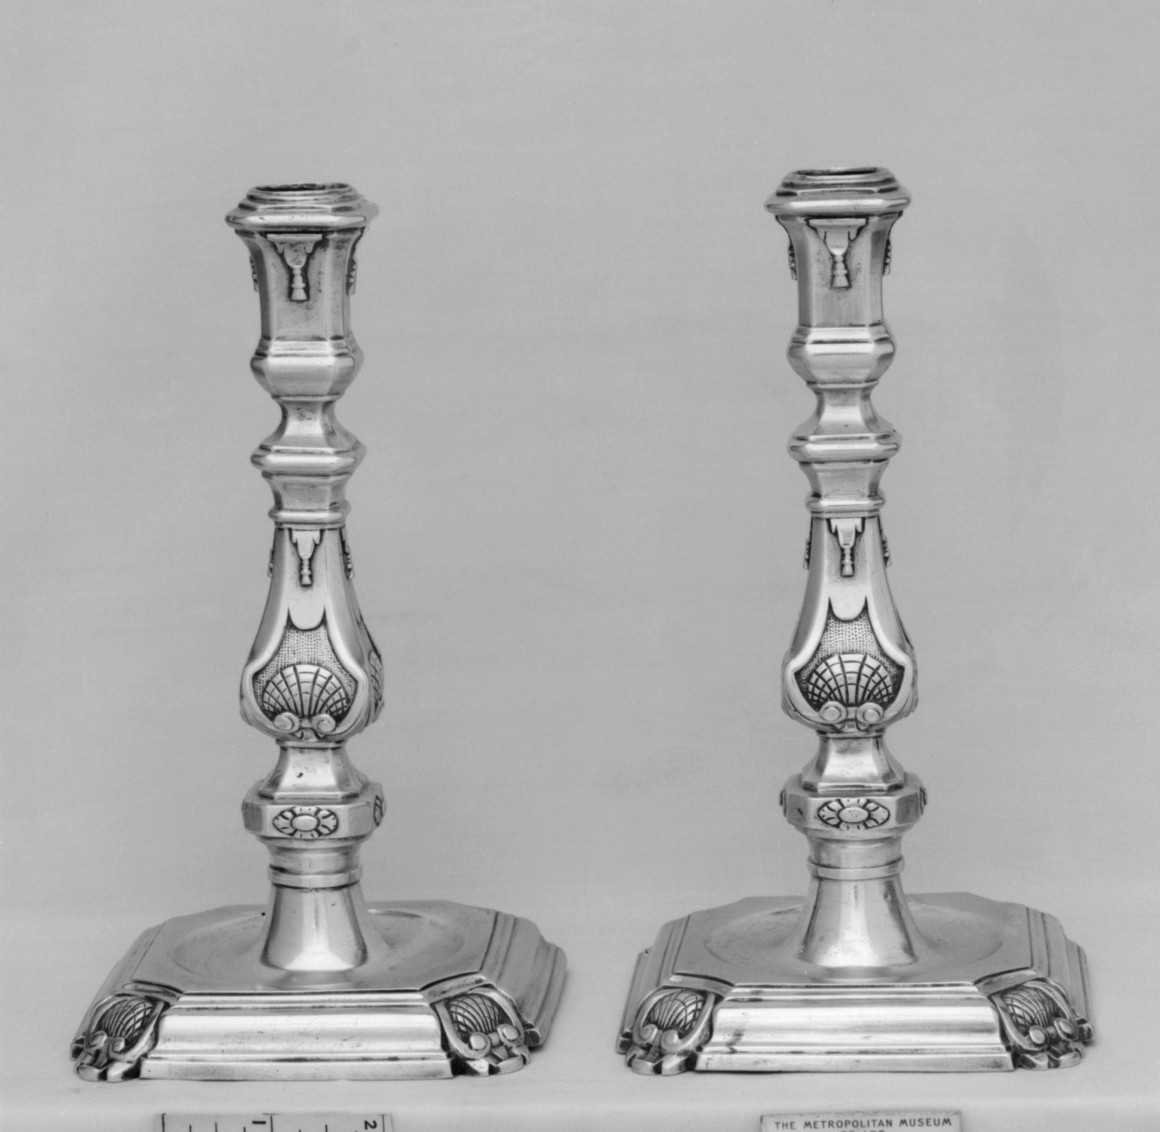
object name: candlestick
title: Pair of candlesticks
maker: abraham ten brinck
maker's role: maker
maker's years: 1716-1747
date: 1731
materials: silver